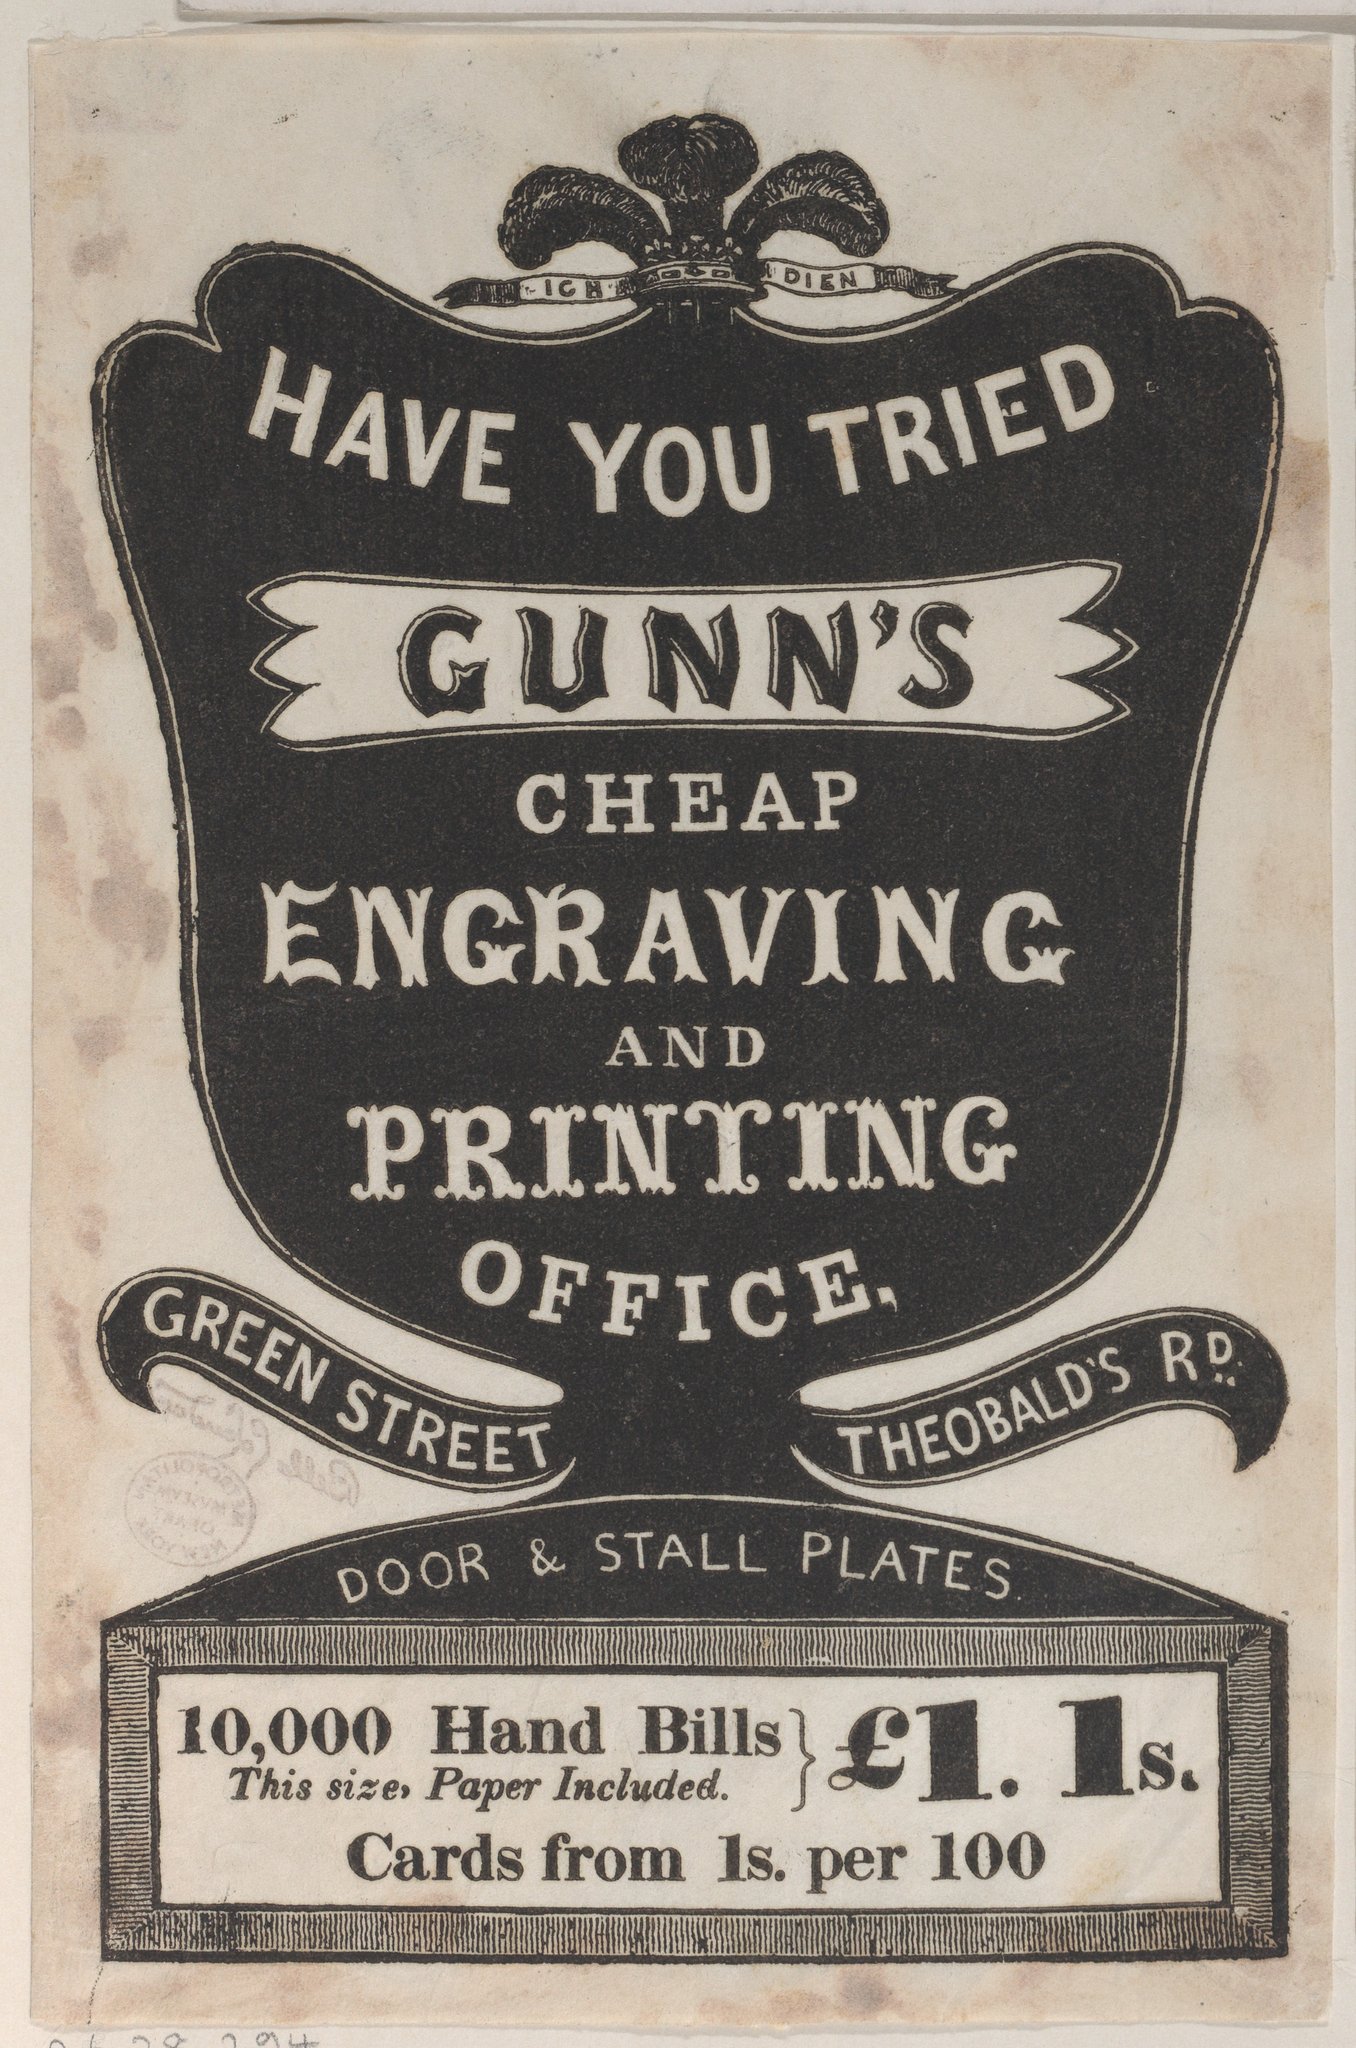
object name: print, trade card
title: Trade Card for Gunn's Cheap Engraving and Printing Office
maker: anonymous, british, 19th century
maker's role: artist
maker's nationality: british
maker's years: 1800-1900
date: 1801-1900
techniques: engraving